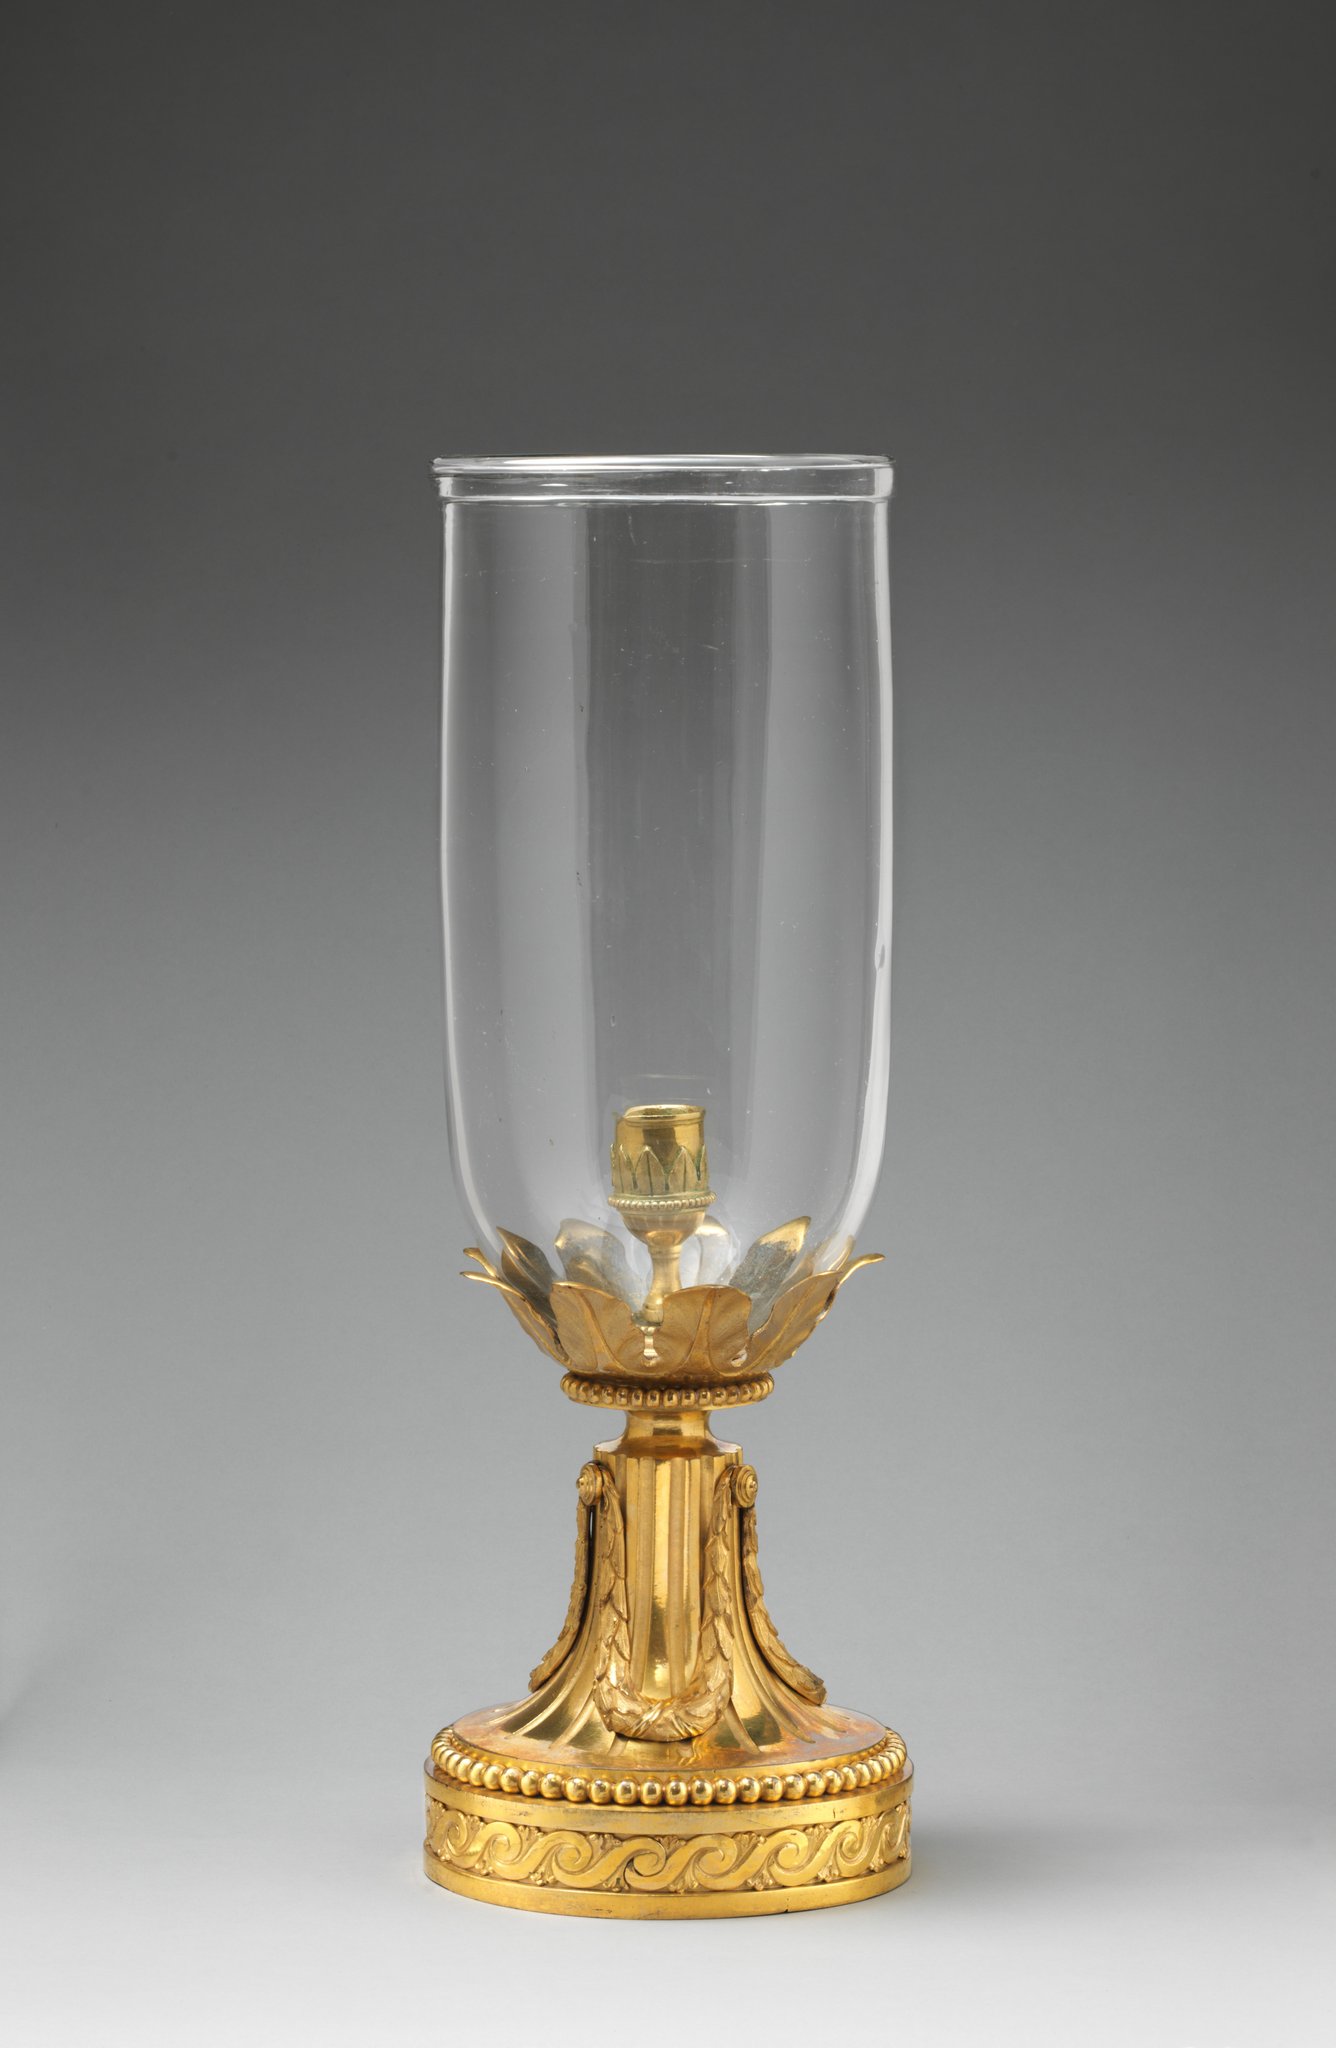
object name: candlestand with shade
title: Candlestand (flambeau de jardin) with shade (one of a pair)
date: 1770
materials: gilt bronze, glass